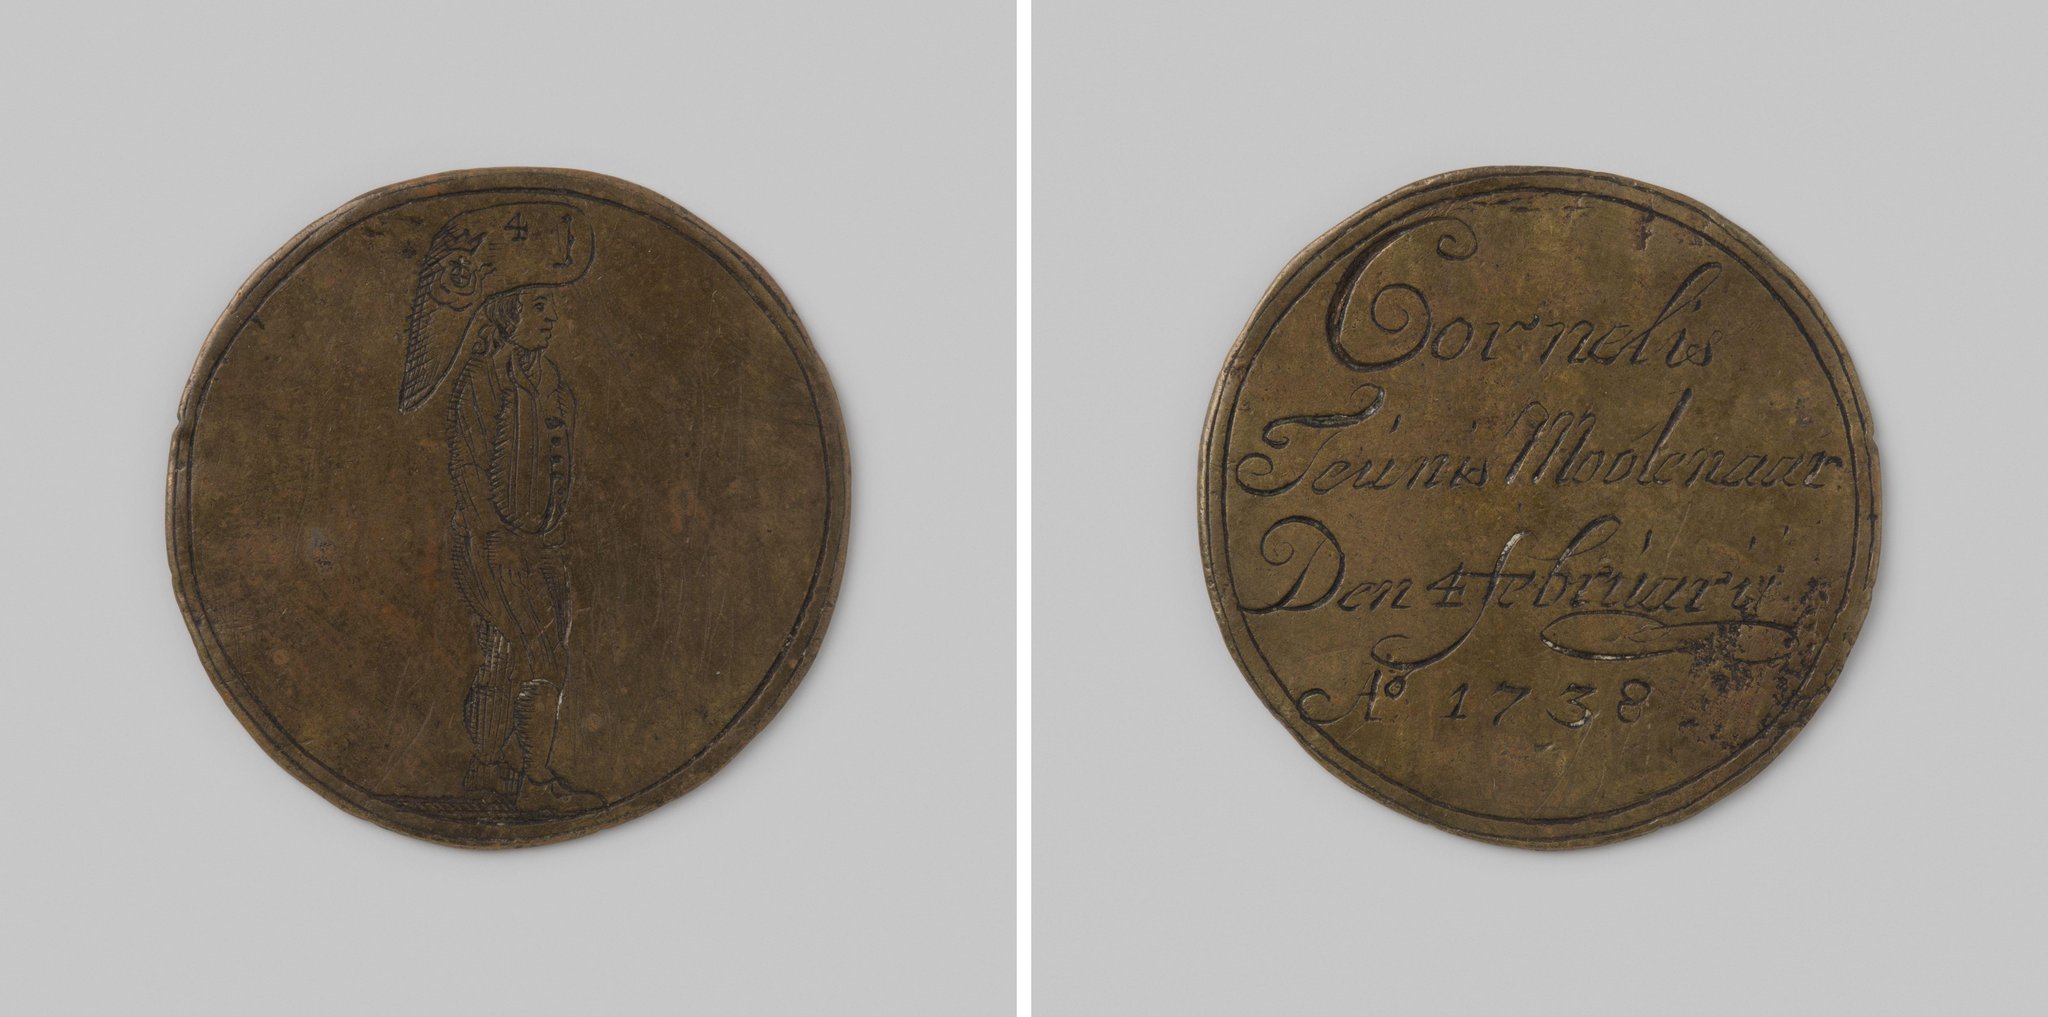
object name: medal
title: Presentiepenning van het Korendragers en -stortersgilde te Amsterdam, 1693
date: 1693-1738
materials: brass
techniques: engraving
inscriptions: inscription: ‘Cornelis / Teunis Moolenaar / Den 4 februarij / A° 1738’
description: Ronde plaat messing gegraveerd op de voorzijde korendrager naar rechts, met zak genummerd 4, op de keerzijde vier regels tekst, op naam van Cornelis Teunis Moolenaar 4 februari 1738